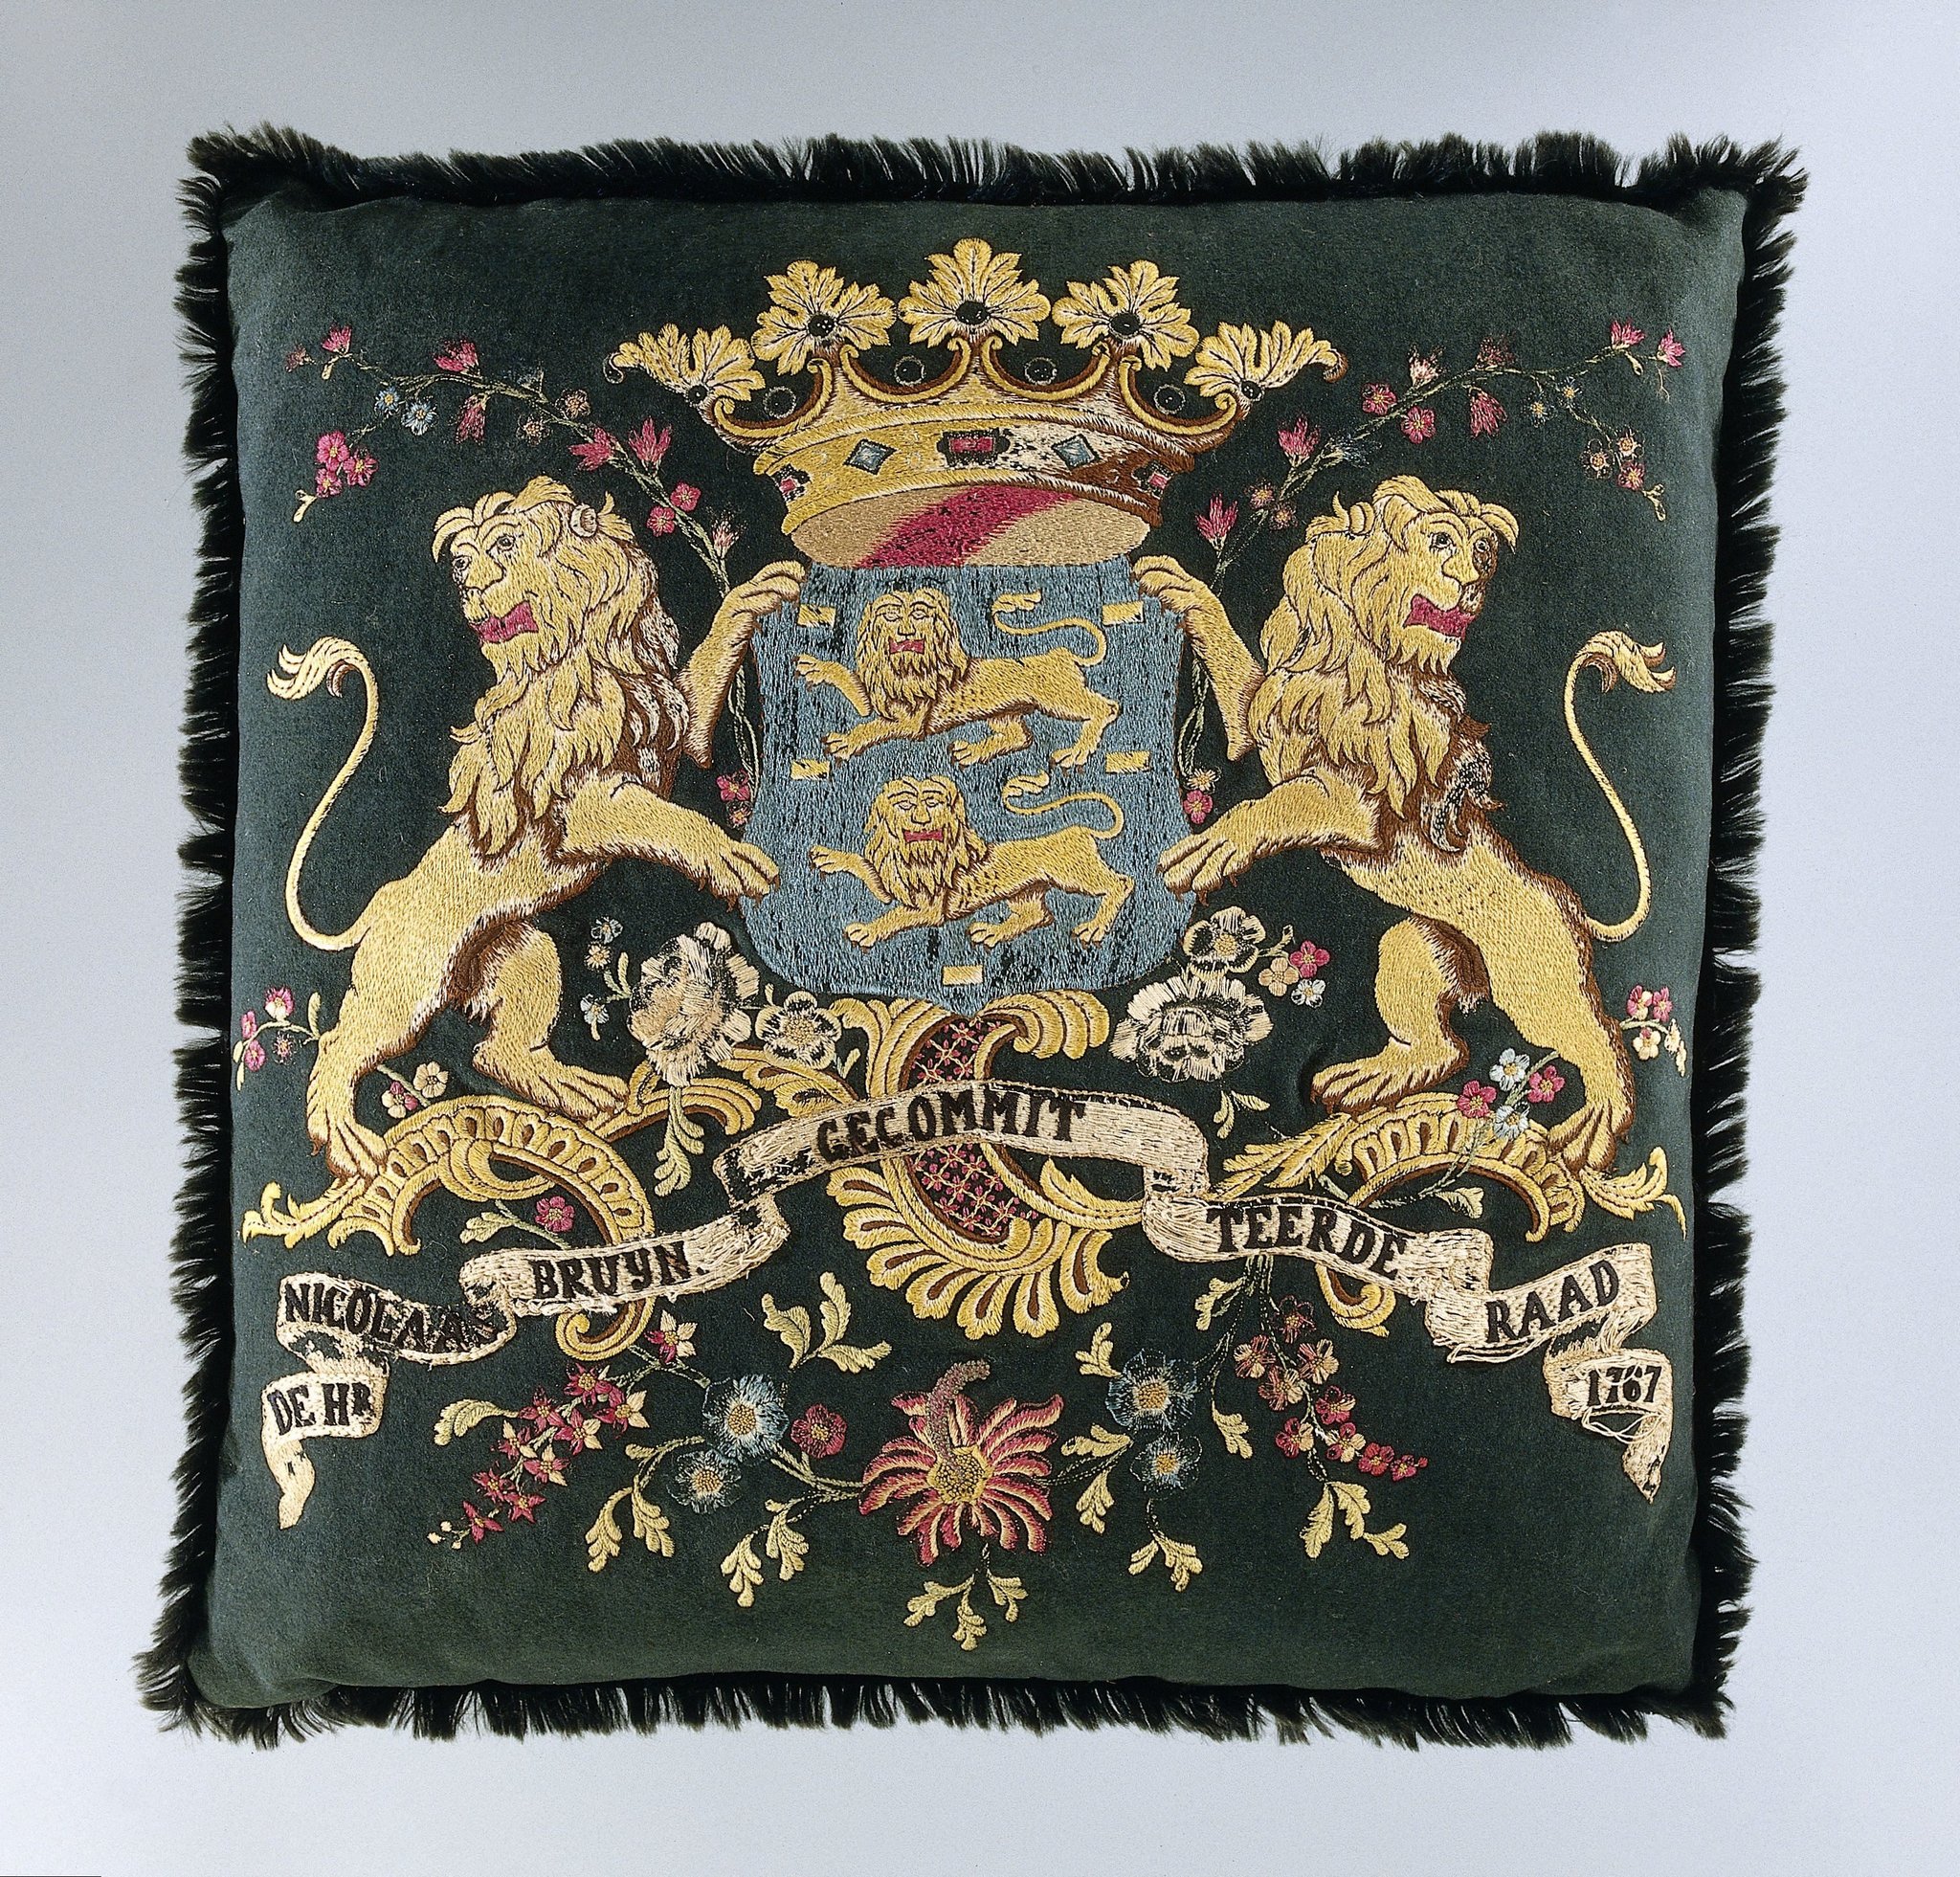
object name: magistratenkussen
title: Magistraatskussen met het wapen van West-Friesland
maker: Anonymous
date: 1767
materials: silk, wool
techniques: embroidered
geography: west frisia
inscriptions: inscription: ‘DE Hr NICOLAAS BRUYN GECOMMIT TEERDE RAAD 1767’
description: Magistratenkussen van donkergroen laken met het gekroonde wapenschild van West-Friesland en als schildhouders twee leeuwen, het geheel in zijden borduursel. Onder het wapenschild is een banderol aangebracht met de inscriptie "DE HR. NICOLAAS.BRUYN.GECOMMIT.TEERDE.RAAD.1767". Het kussen is afgewerkt met een korte donkergroenzijden franje en gevoerd met okergeel satinet.